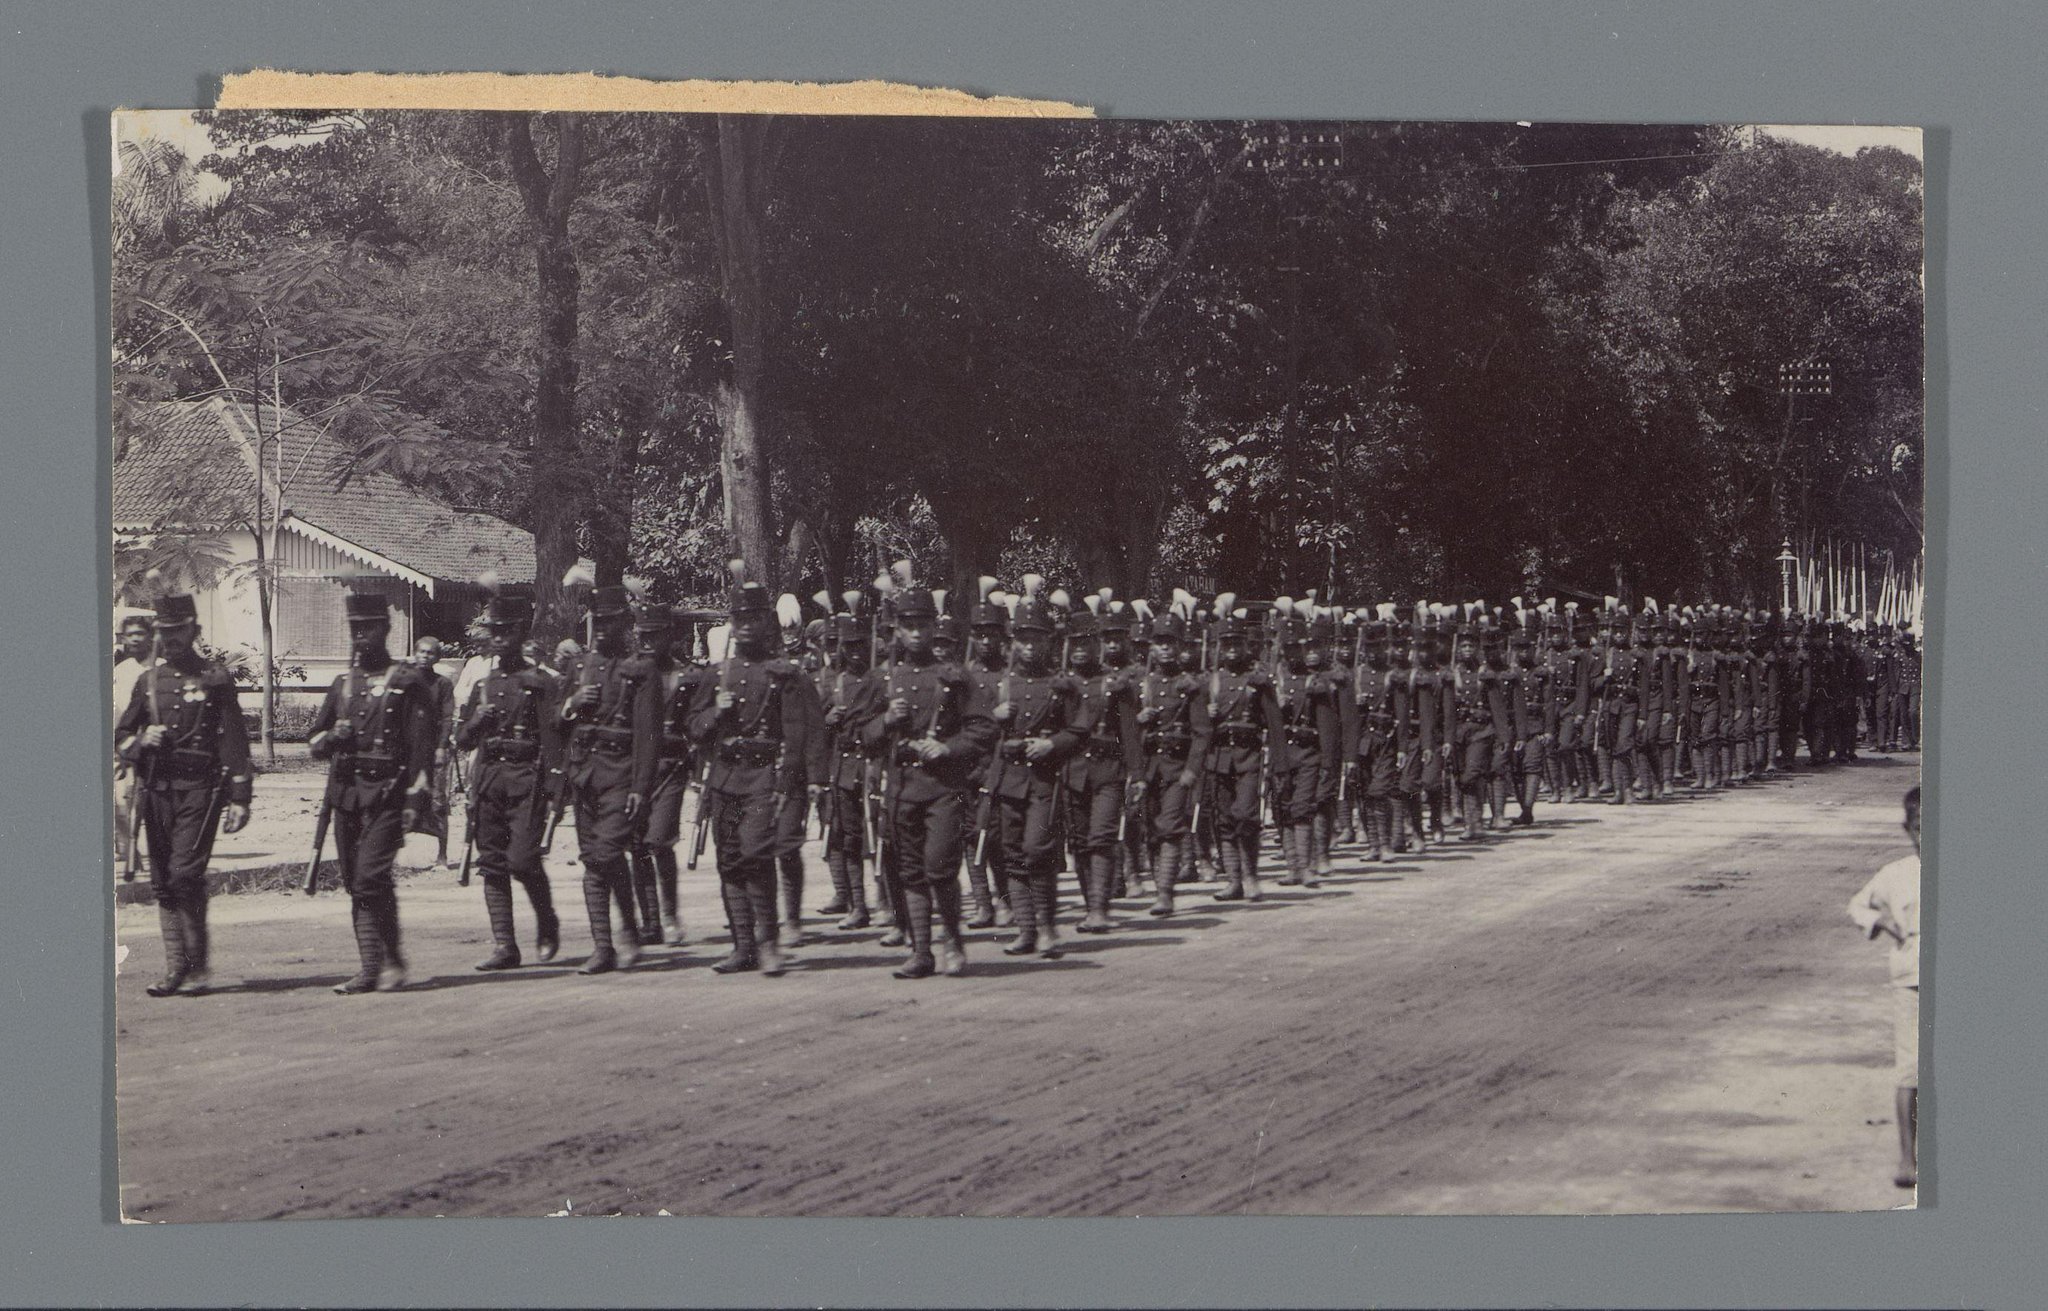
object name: photograph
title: Marcherende Indische militairen op de weg van Jogyakarta naar Toegoe op Java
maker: Anonymous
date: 1904-1917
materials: photographic support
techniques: gelatin silver print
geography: java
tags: troop movements, transportation, street (+ city(-scape) with figures, staffage), java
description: Onderdeel van Familiealbum met foto's van een familie in de voormalige kolonie Nederlands-Indië en van een suikerfabriek in Purworejo.